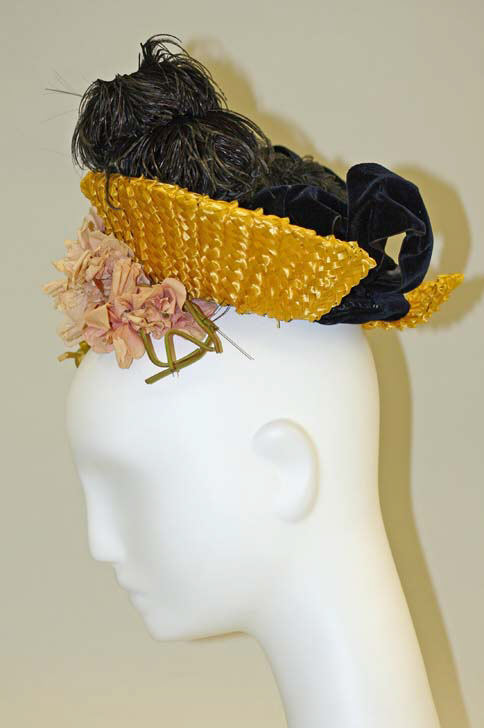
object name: hat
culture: french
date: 1890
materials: silk, fiber, metal